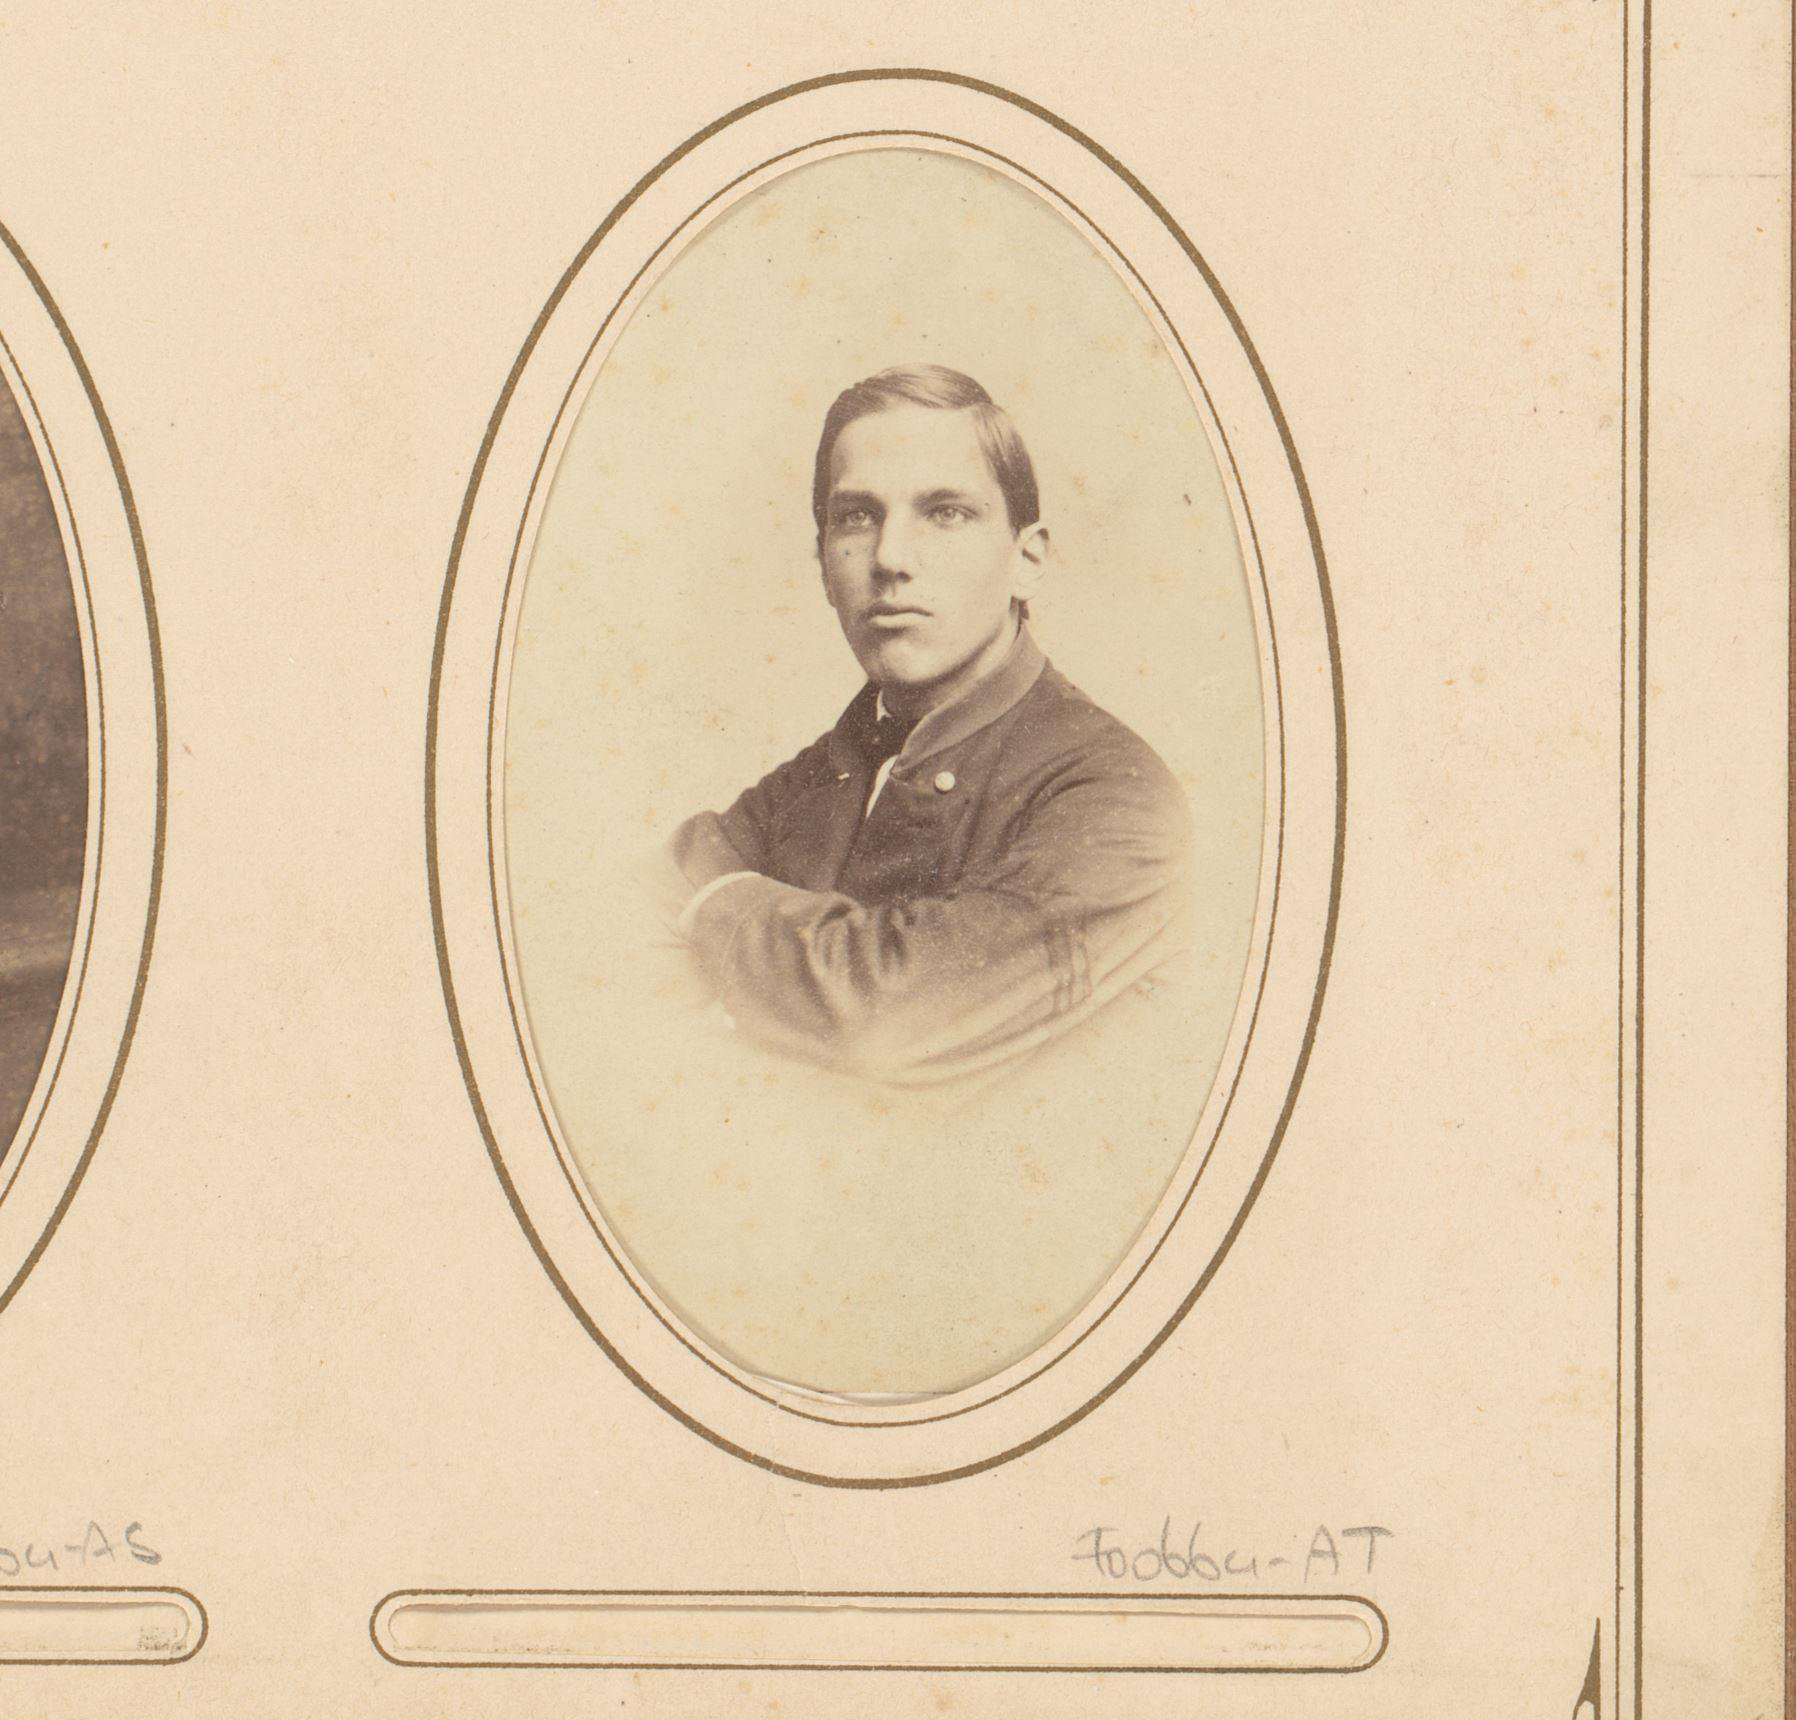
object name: carte de visite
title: Portret van een jongeman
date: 1865-1890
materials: cardboard, photographic support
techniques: albumen print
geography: amsterdam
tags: historical persons, youth, adolescent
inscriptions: number: ‘2950’, name: ‘[Brietonje van Diep]’, inscription: ‘Photogr Atelier/ Wegner & Mottu/ Kalverstraat/ Over den Heyligenweg D.26/ Amsterdam’